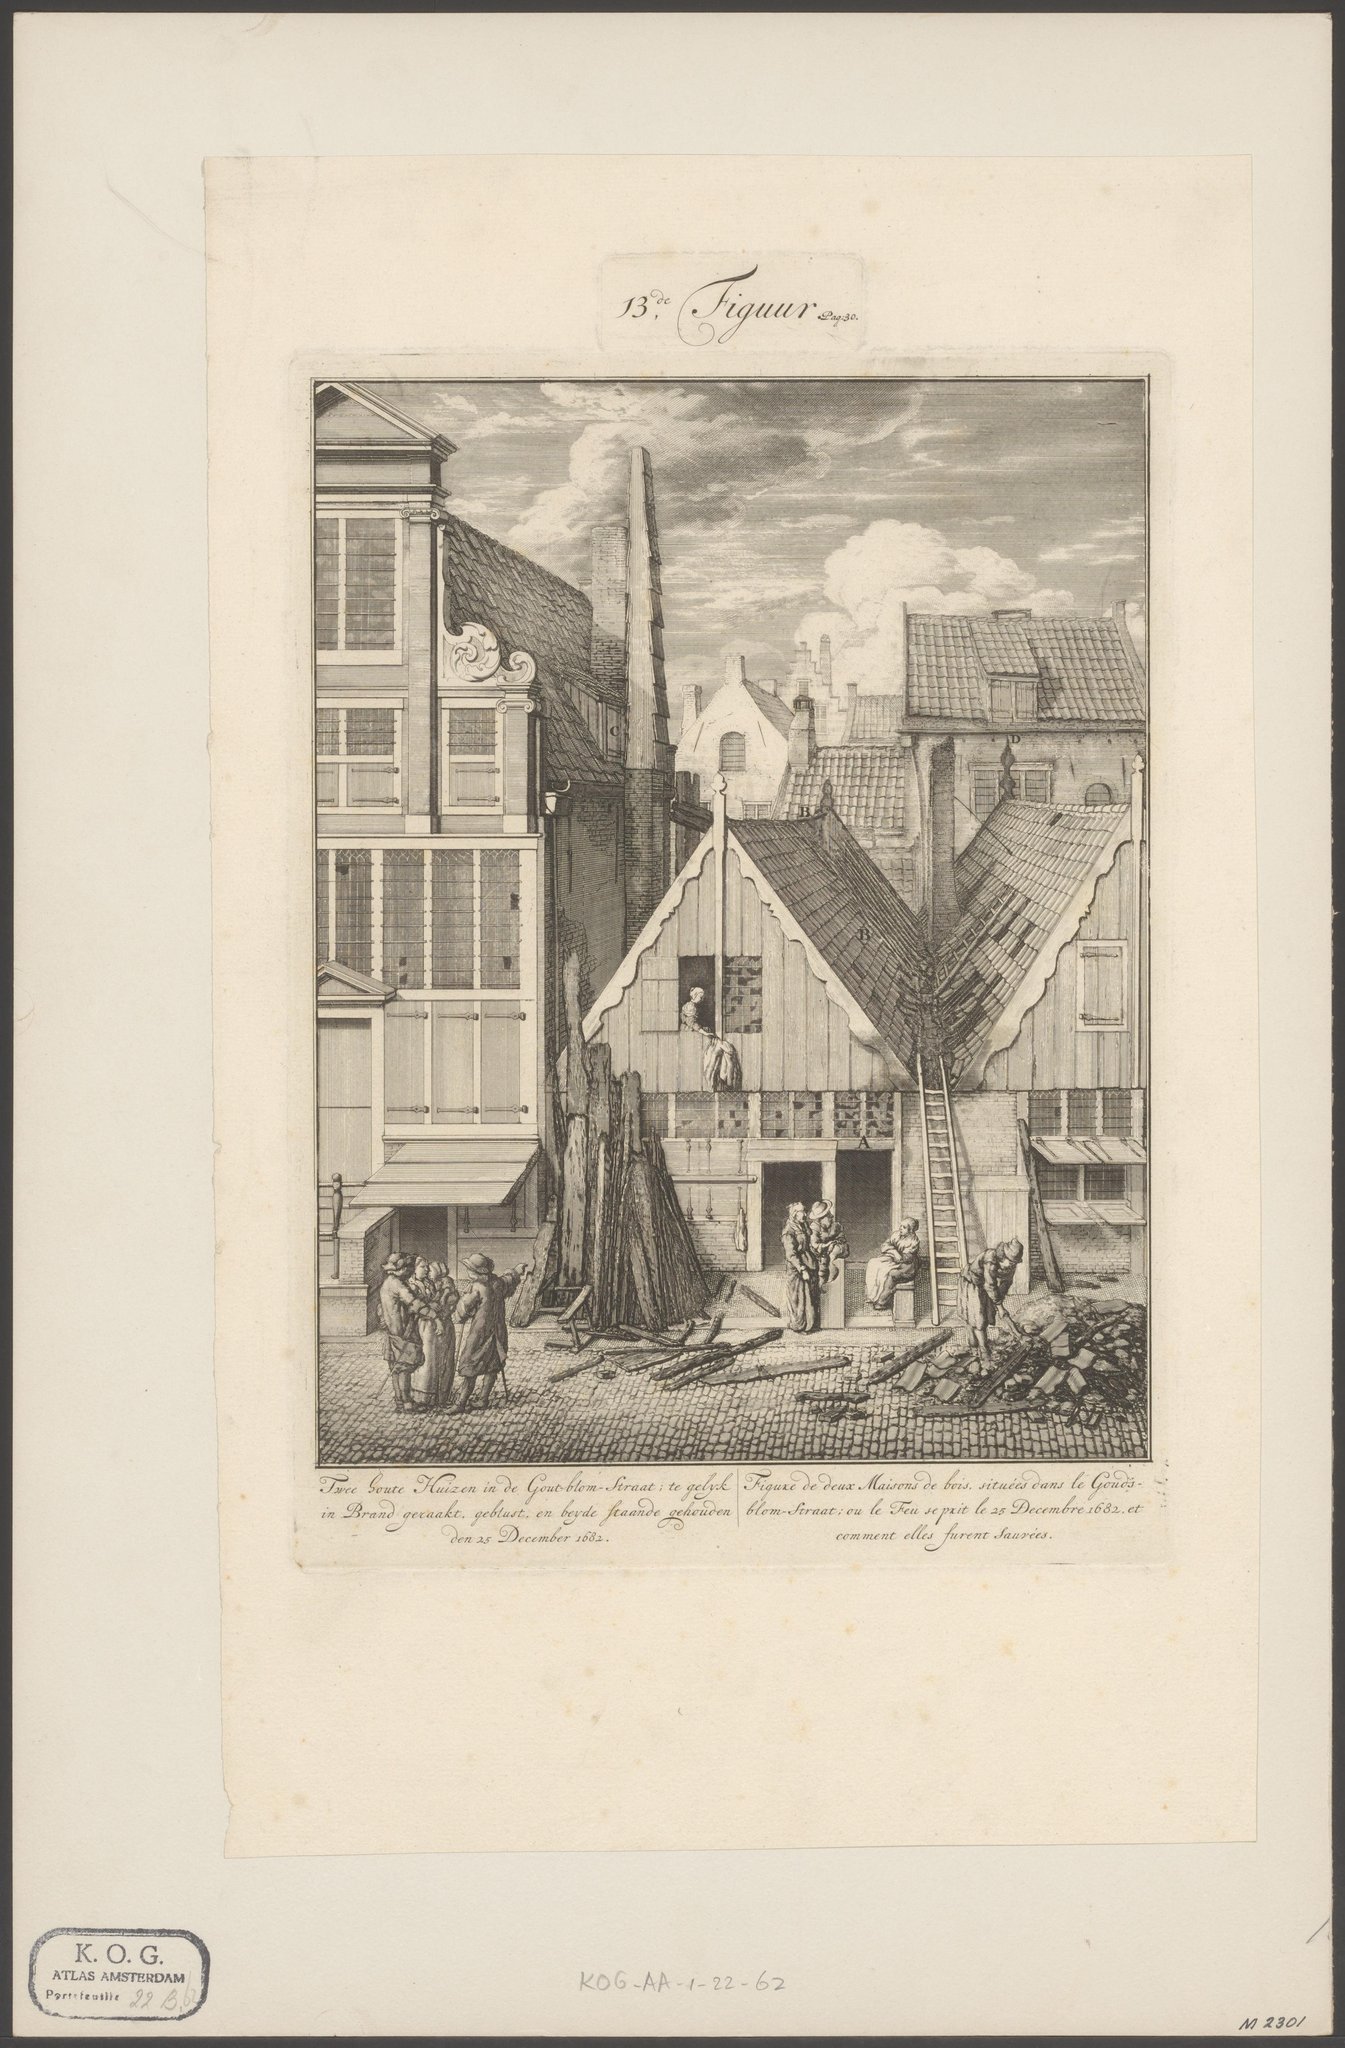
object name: print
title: Uitgebrande huizen in de Goudsbloemstraat te Amsterdam, 1682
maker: jan van der heyden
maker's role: draughtsman, painter, print maker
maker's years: 1637-1712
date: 1690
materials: paper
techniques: engraving, etching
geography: amsterdam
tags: print maker, draughtsman, jan van der heyden, urban housing, ruin of a building ~ architecture, fire-fighting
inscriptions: collector's mark: Lugt 1641b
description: Twee uitgebrande, maar staande gebleven huizen in de Goudsbloemstraat te Amsterdam, na een brand op 25 december 1682. Drie regels onderschrift in het Nederlands en het Frans. Centraal bovenaan: 13de Figuur. Pag: 30. Onderwerpsrubriek binnen de Atlas Amsterdam: Gemeentewerken: B. Branden in particuliere gebouwen.